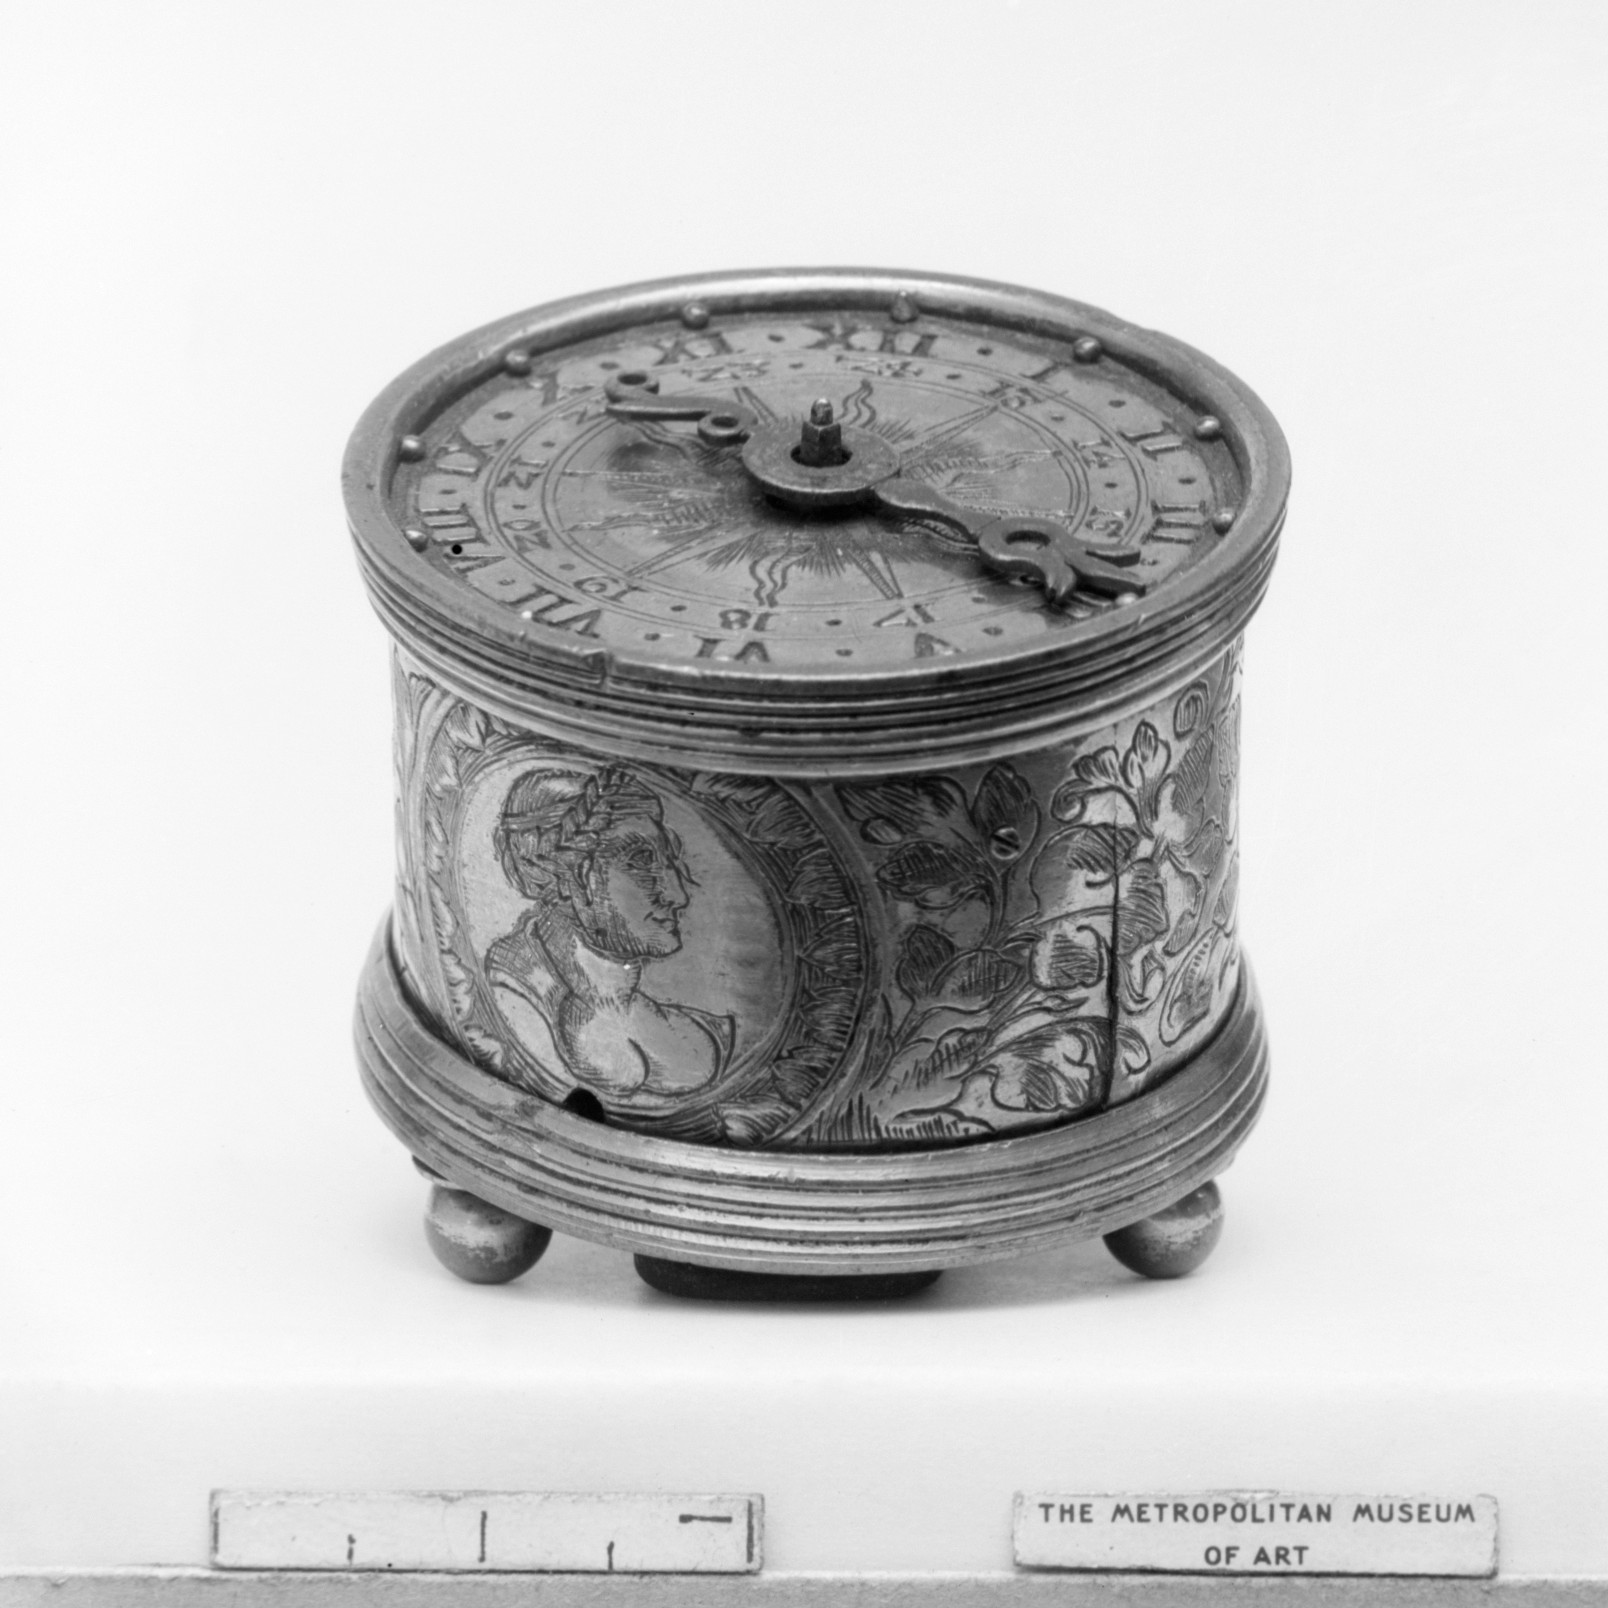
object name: clock watch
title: Clock-watch (part of a set)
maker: charles cabrier i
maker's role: maker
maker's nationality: british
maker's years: 1690-1736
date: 1567-1600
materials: gilt copper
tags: profiles,women